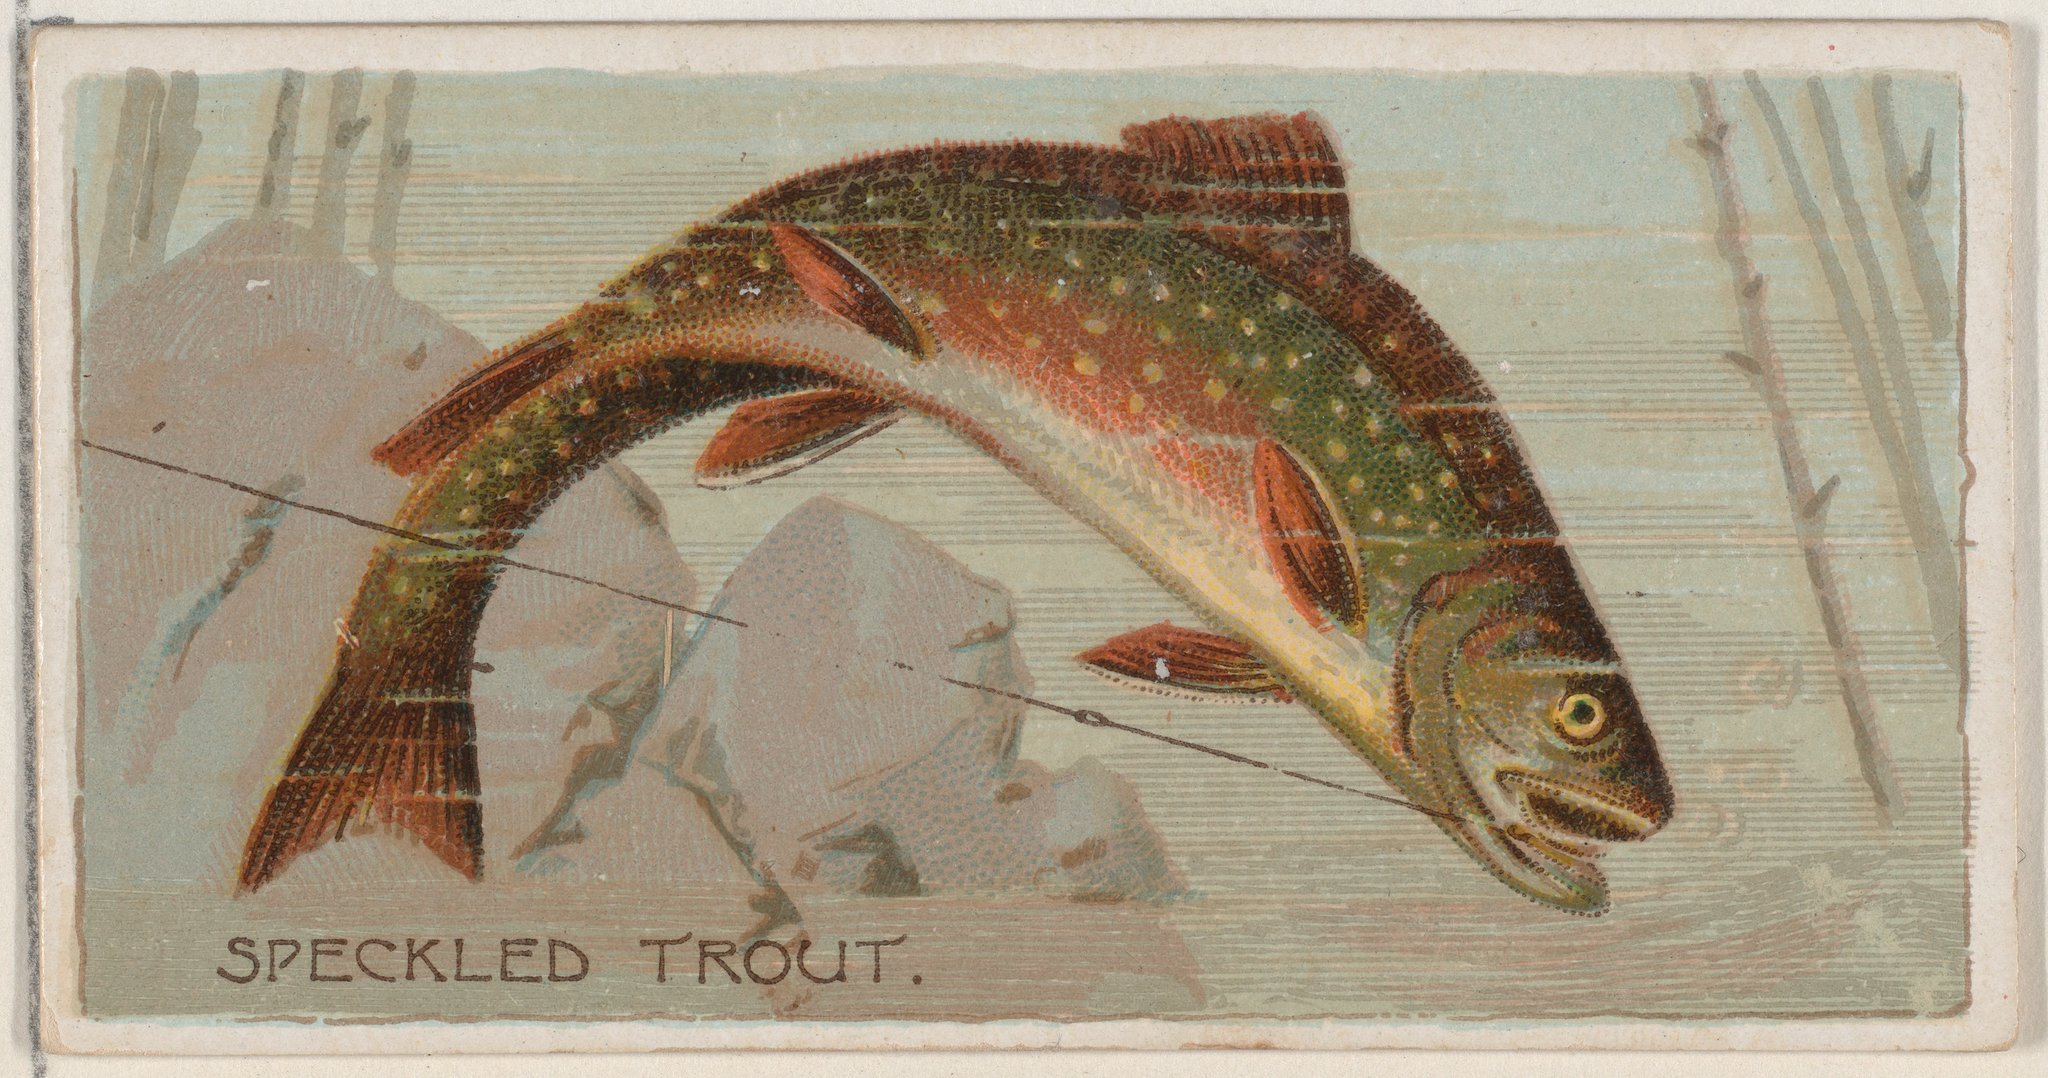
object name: print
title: Speckled Trout, from the series Fishers and Fish (N74) for Duke brand cigarettes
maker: knapp & company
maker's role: lithographer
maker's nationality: american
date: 1888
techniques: color lithograph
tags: fish